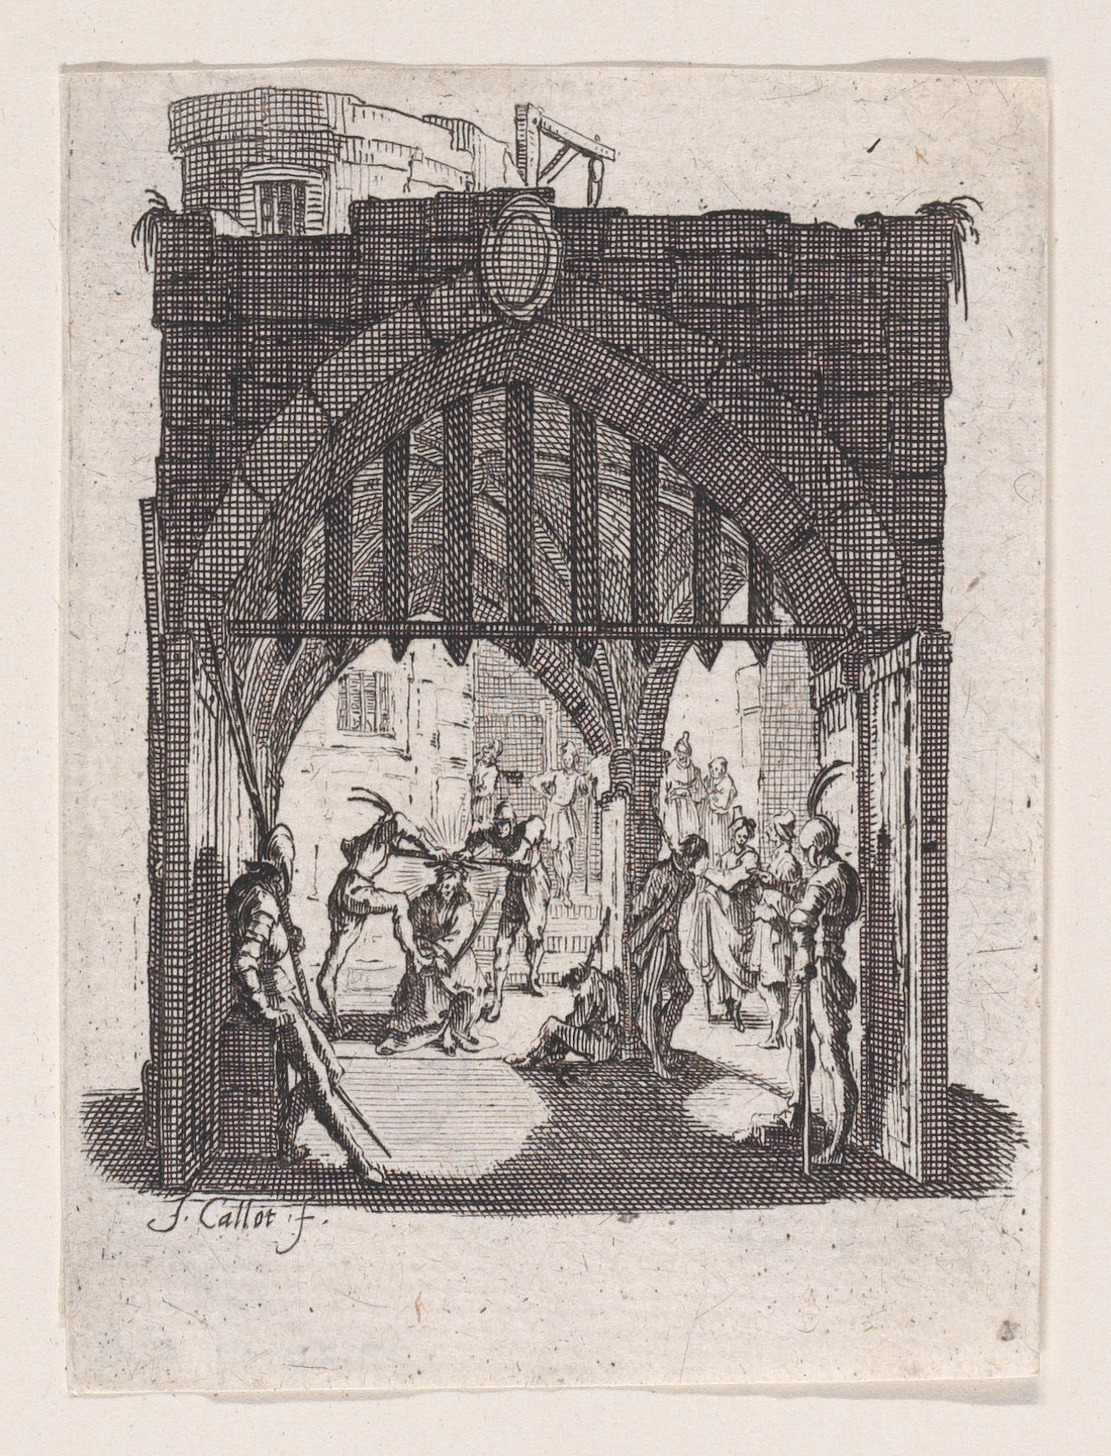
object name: print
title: Le Couronnement d'Épines (The Crowning with Thornes), from "La Petite Passion" (The Little Passion)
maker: jacques callot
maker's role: artist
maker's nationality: french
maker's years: 1592-1635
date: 1624-1625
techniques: etching